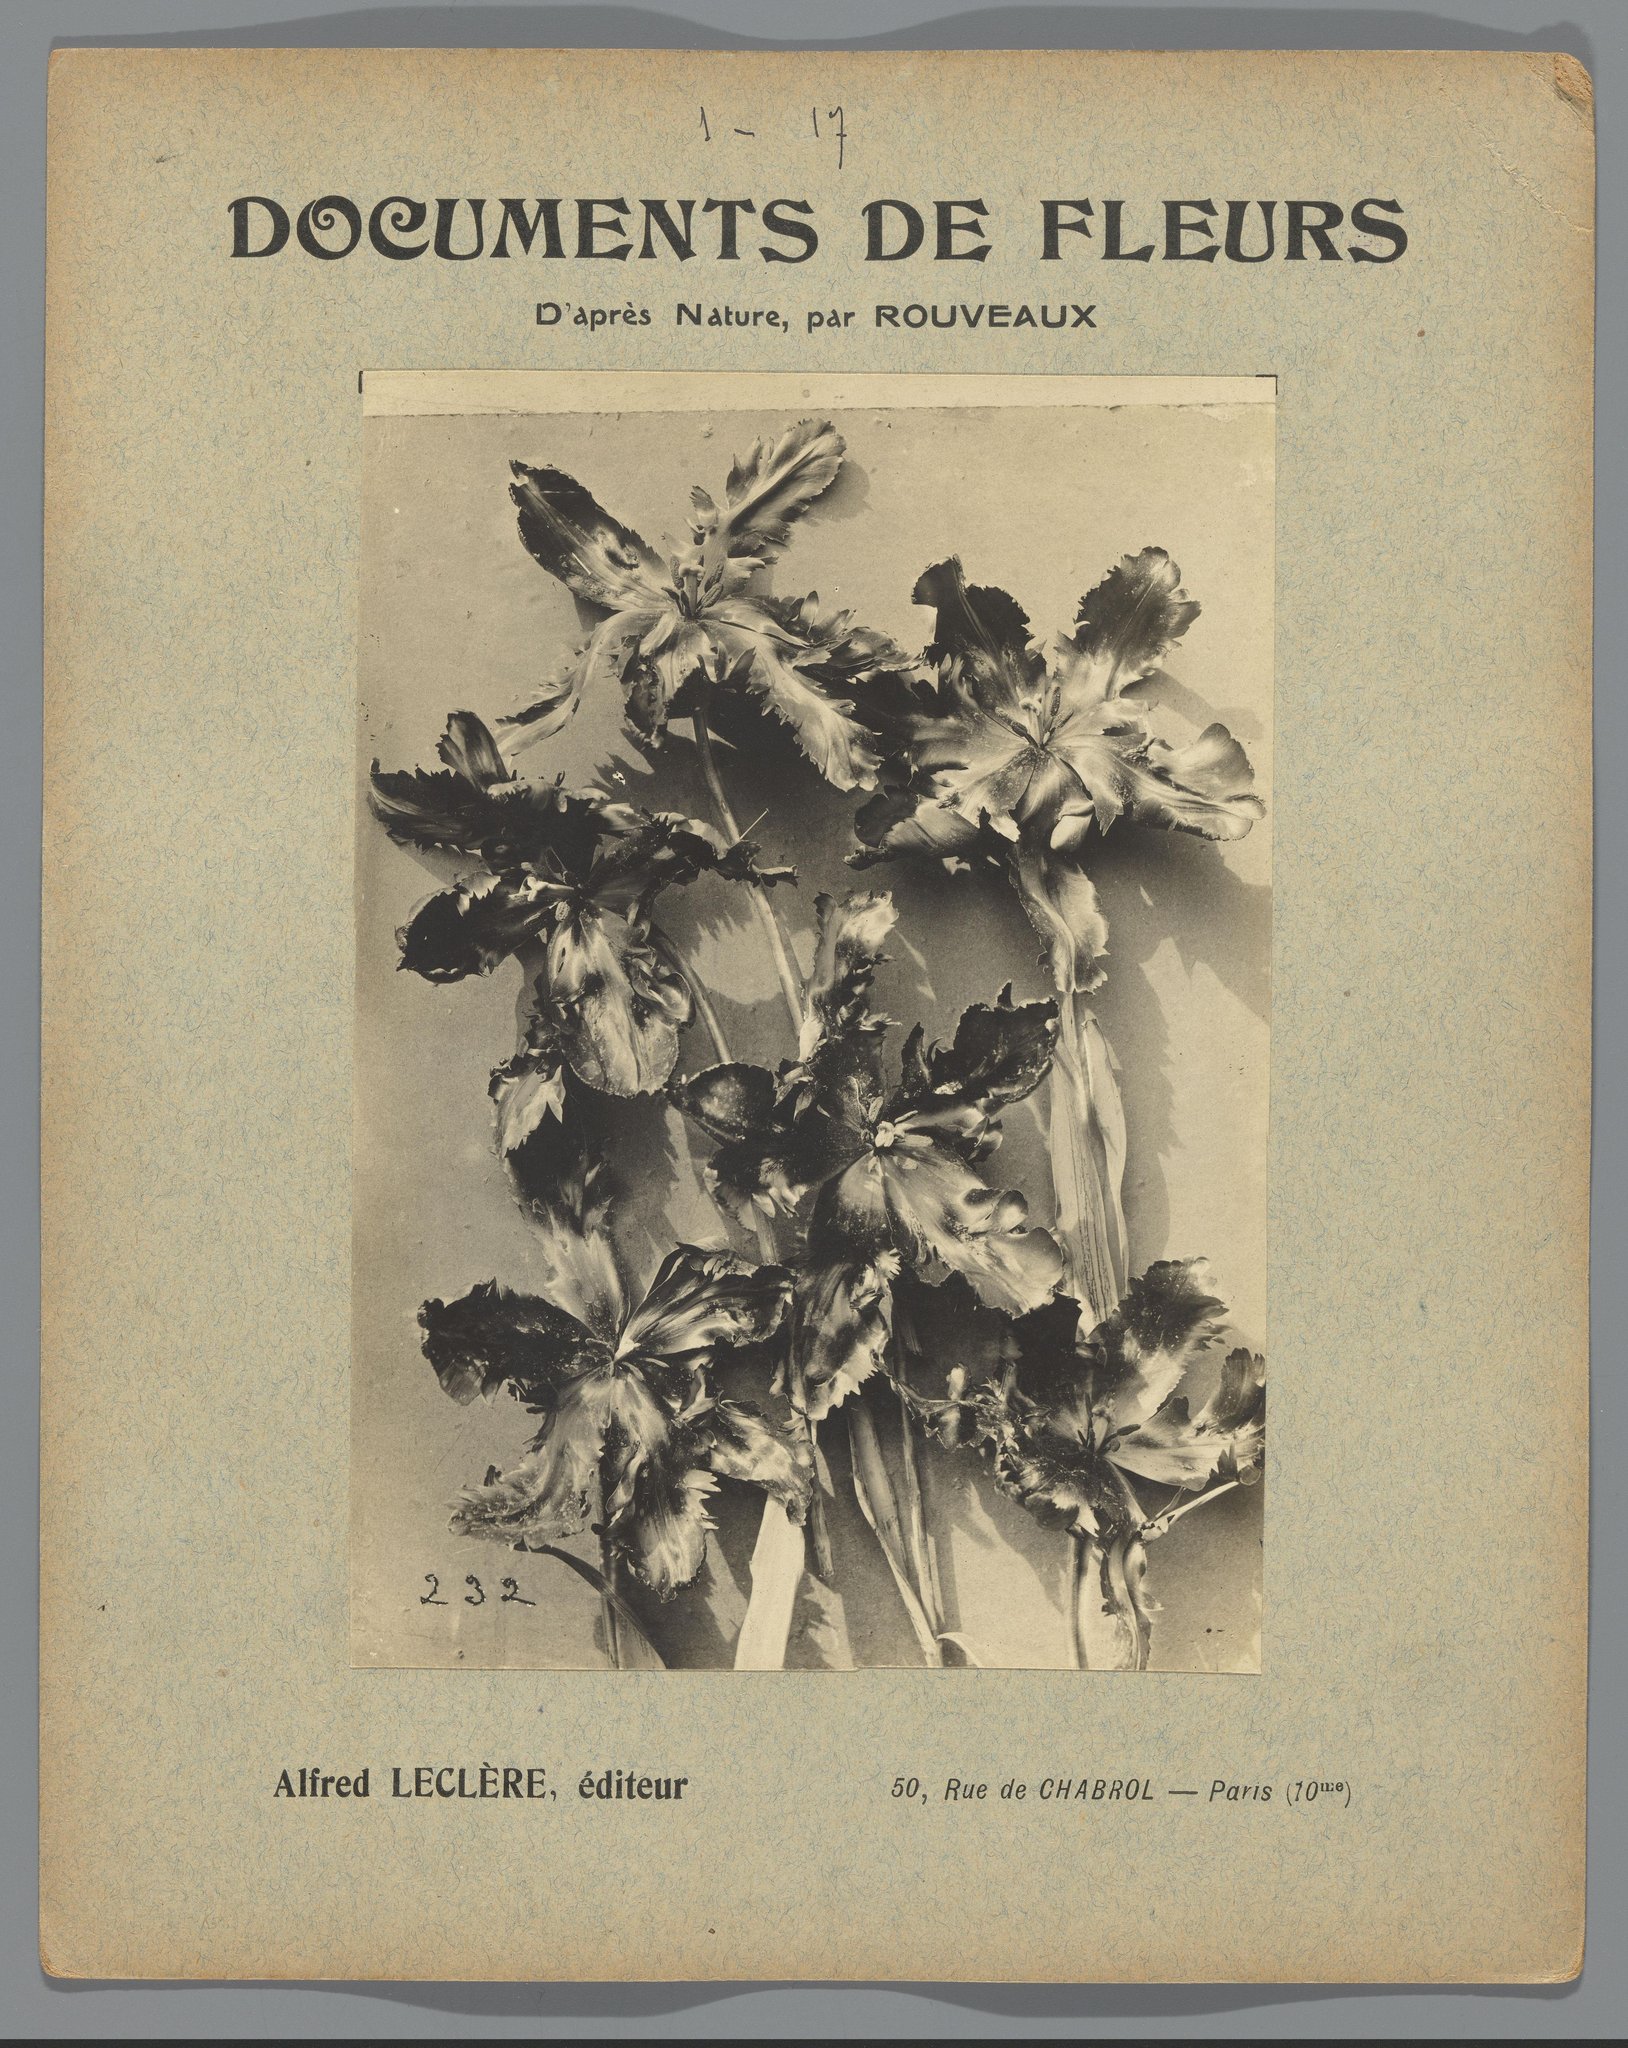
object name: photograph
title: Bloemstudie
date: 1895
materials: photographic support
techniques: gelatin silver print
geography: france